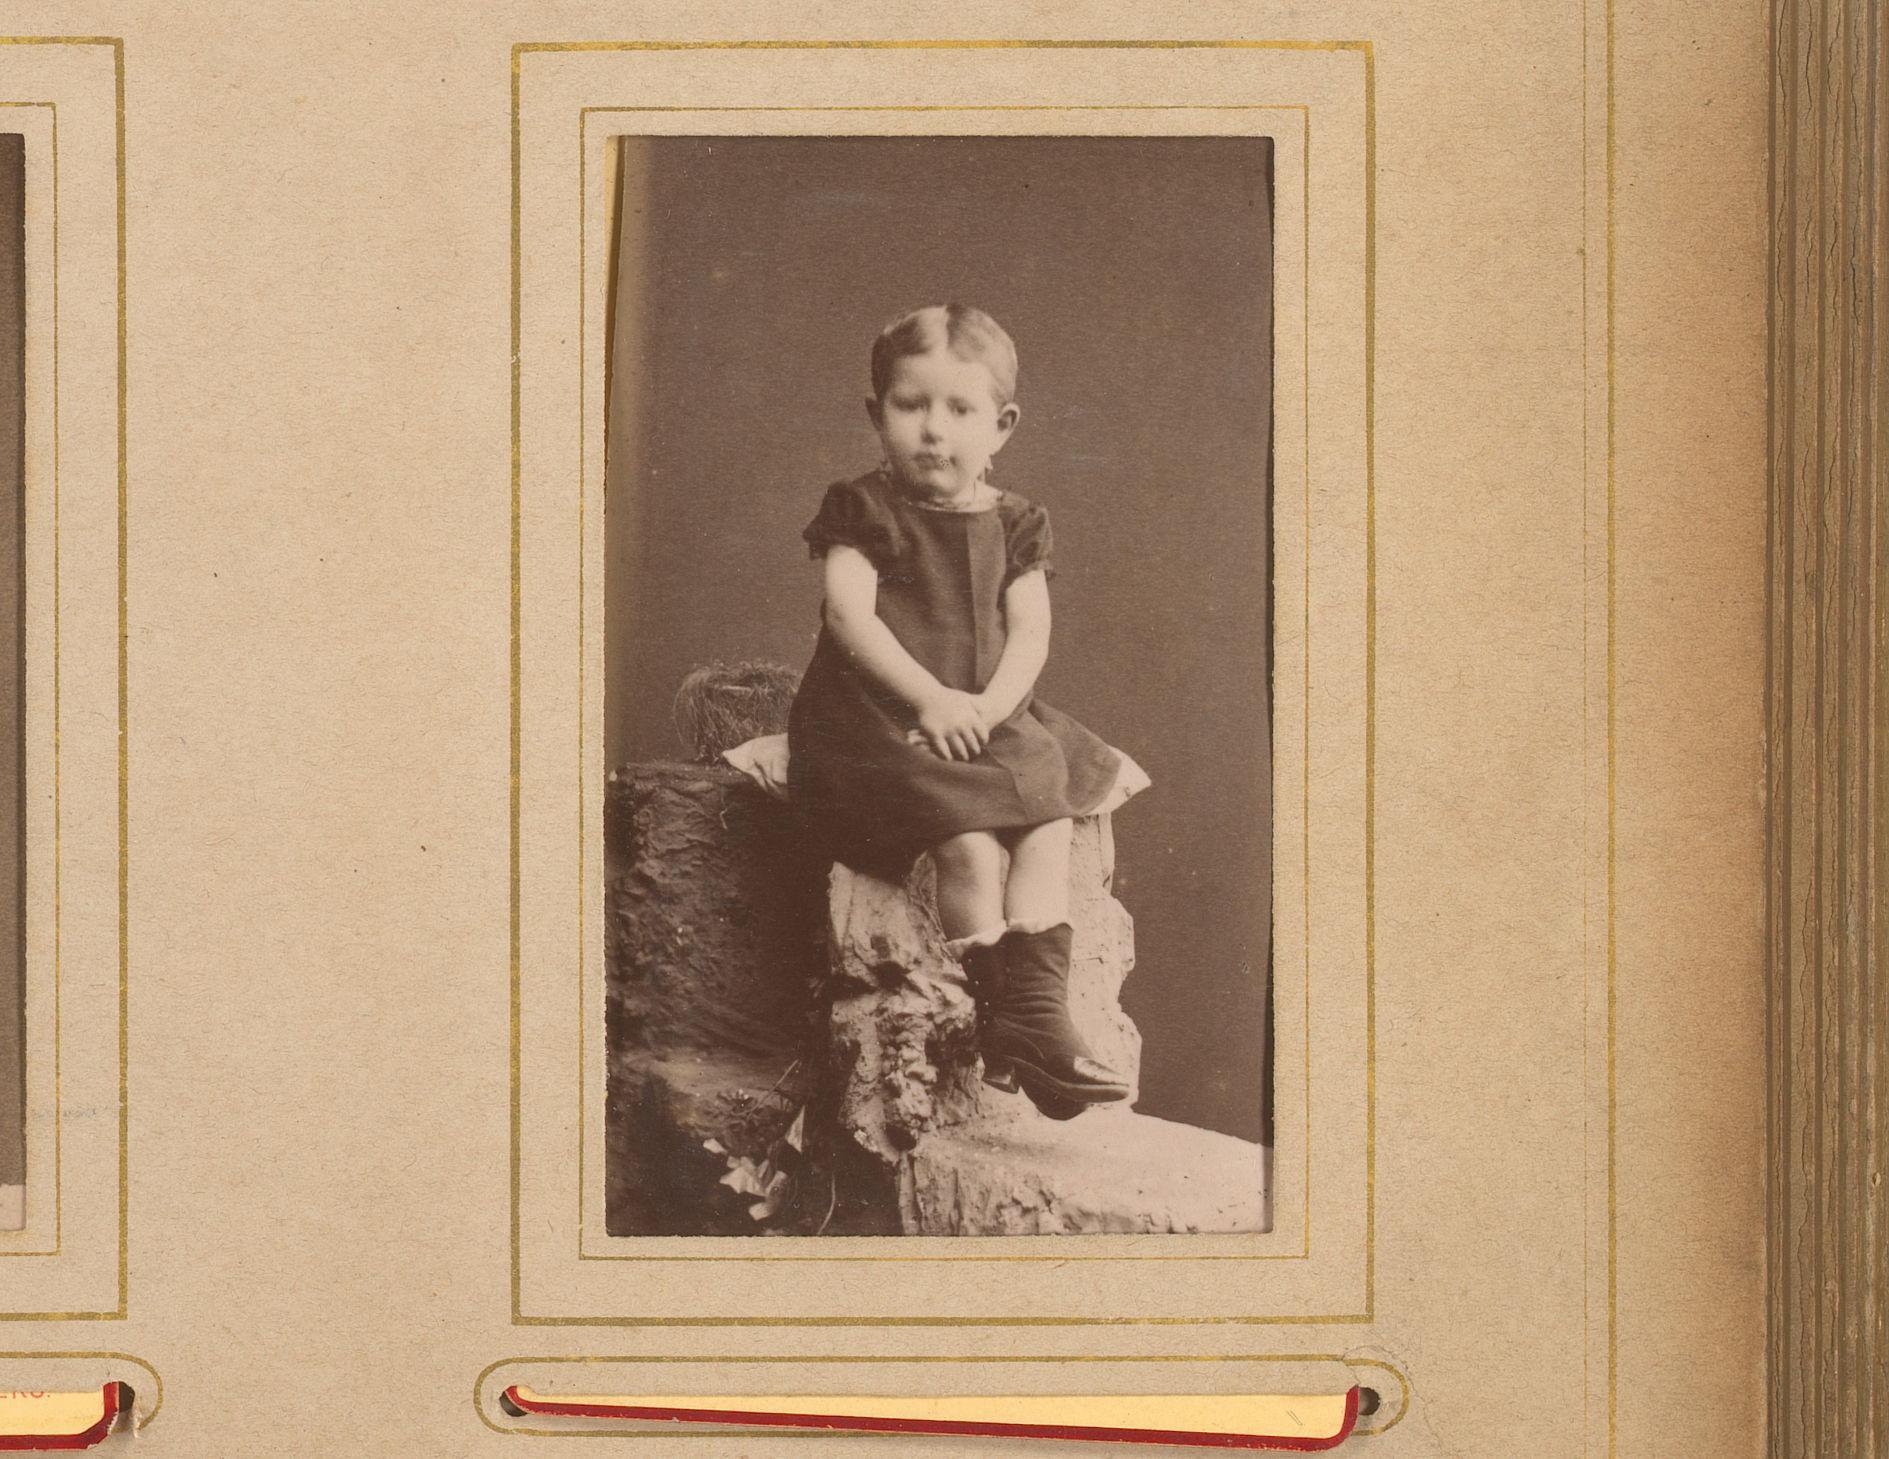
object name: album leaf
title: Portret van een meisje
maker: egide linnig-quveliers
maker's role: fotograaf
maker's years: 1844-1908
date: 1874-1882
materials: cardboard, photographic support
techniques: albumen print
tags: historical persons, girl (child between toddler and youth)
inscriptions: name: ‘Linning-Queveliers Phot Anvers’, inscription: ‘Maison Linning-Queveliers/ Photographie/ Rue de la Commune 20/ (...)’